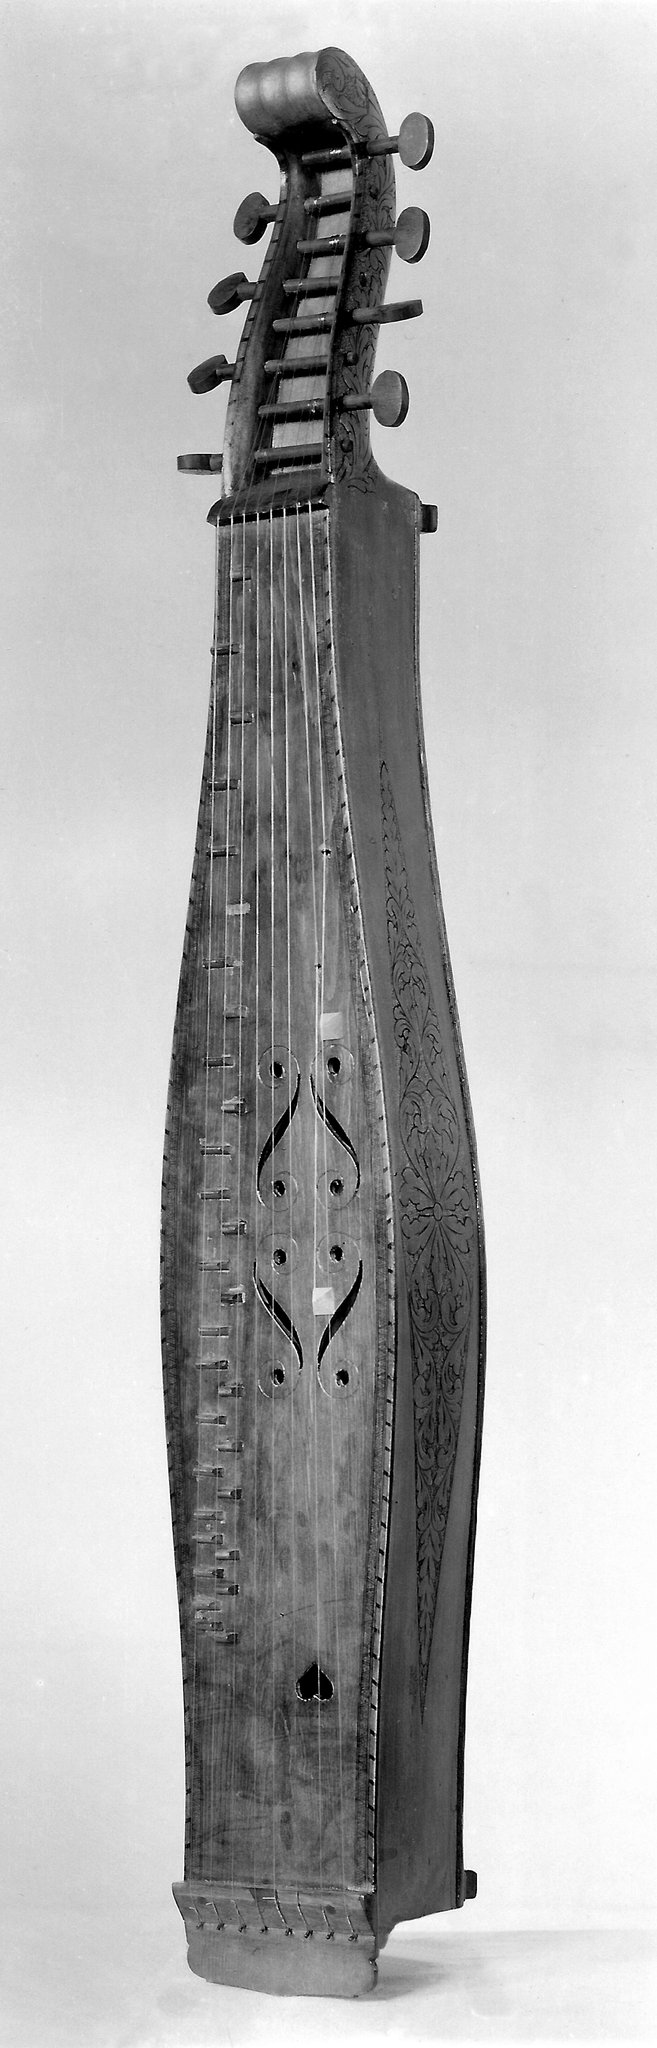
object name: langeleik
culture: norwegian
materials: metal, wood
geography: norway